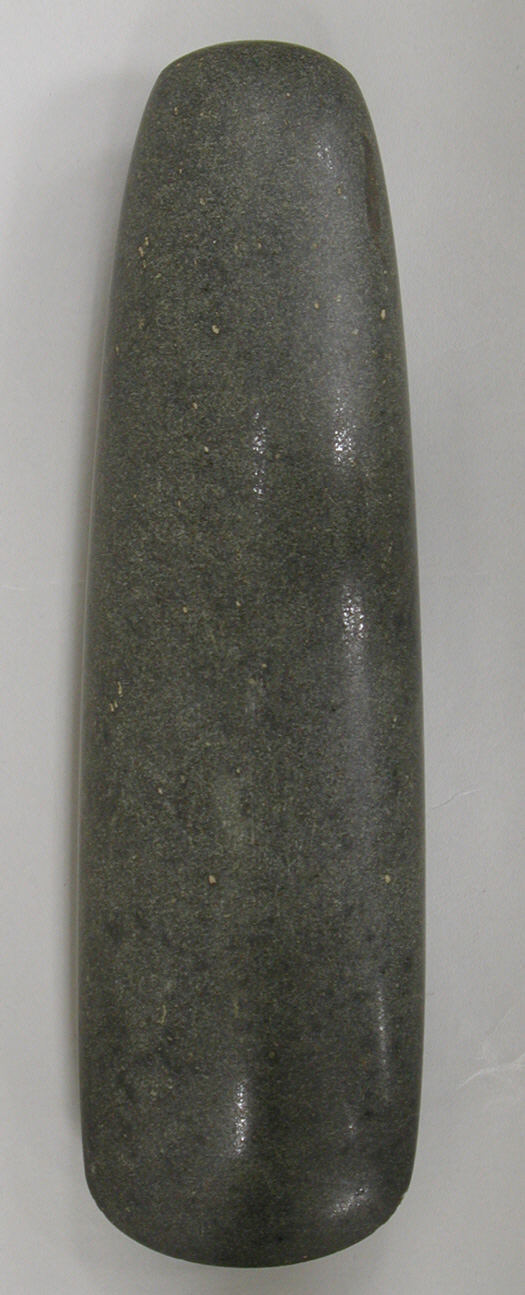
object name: celt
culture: mexican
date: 1501-1600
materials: stone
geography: mexico